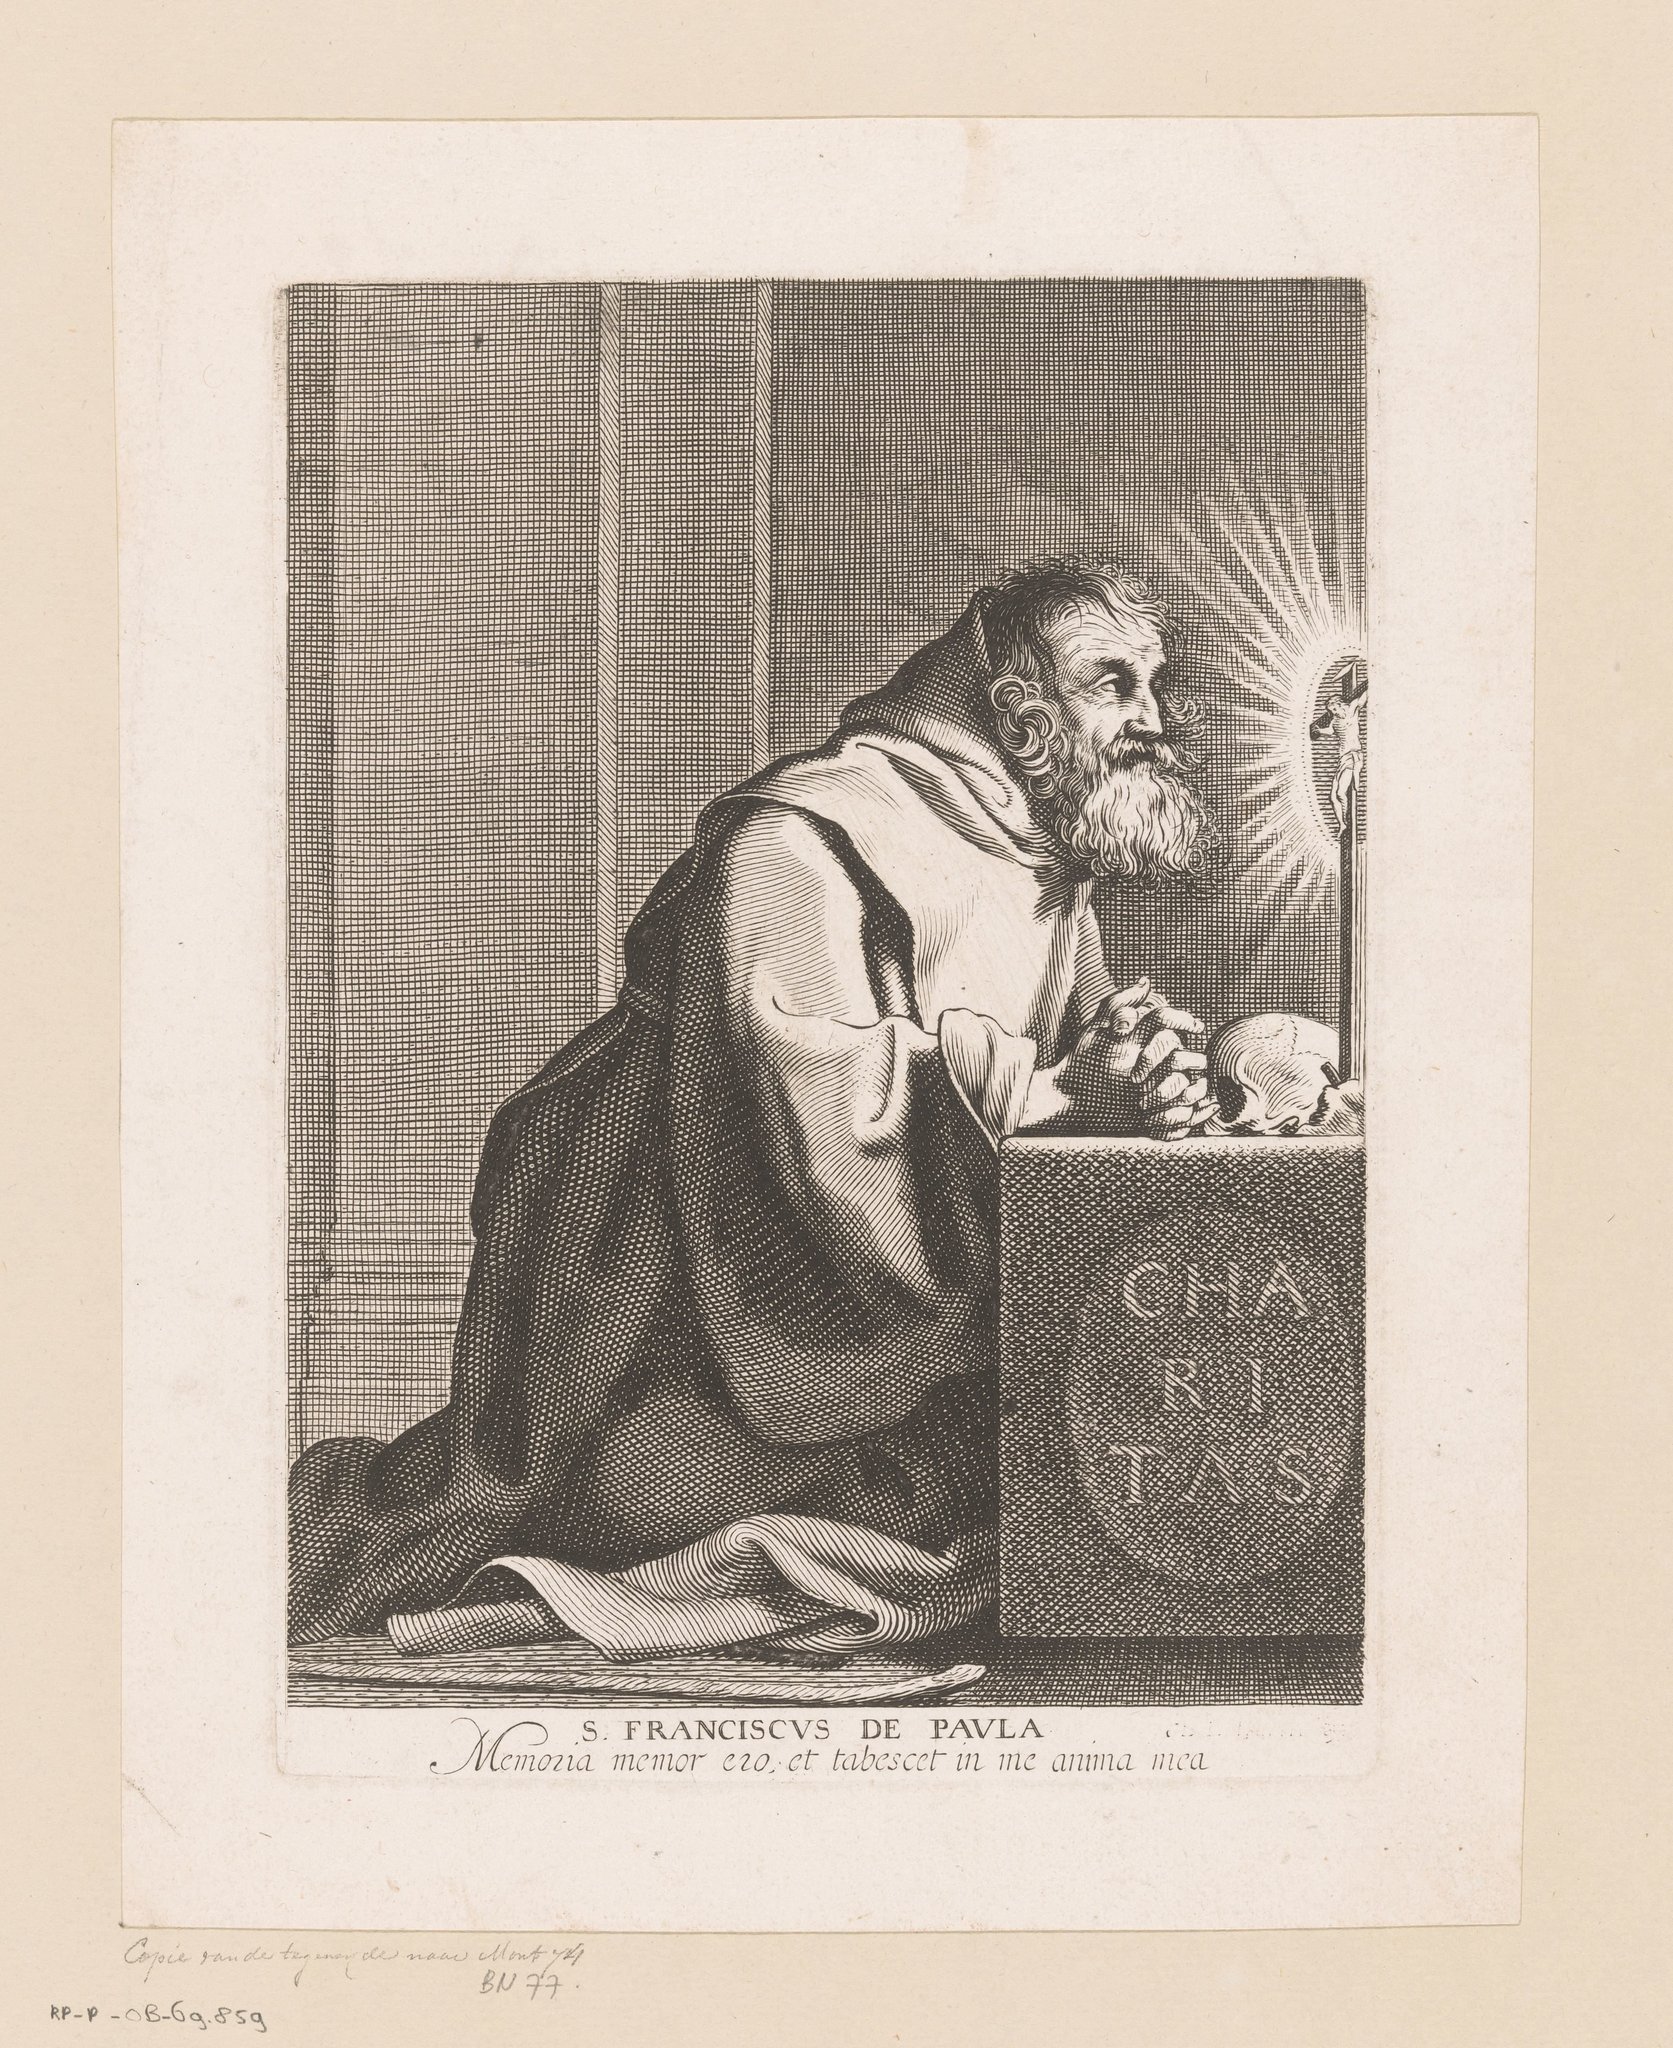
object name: print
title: Knielende H. Franciscus van Paola in gebed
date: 1634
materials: paper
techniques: engraving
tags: historical persons, one or more angels appear to st. francis of paola holding a tablet with the inscription 'charitas'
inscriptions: collector's mark: Lugt 240